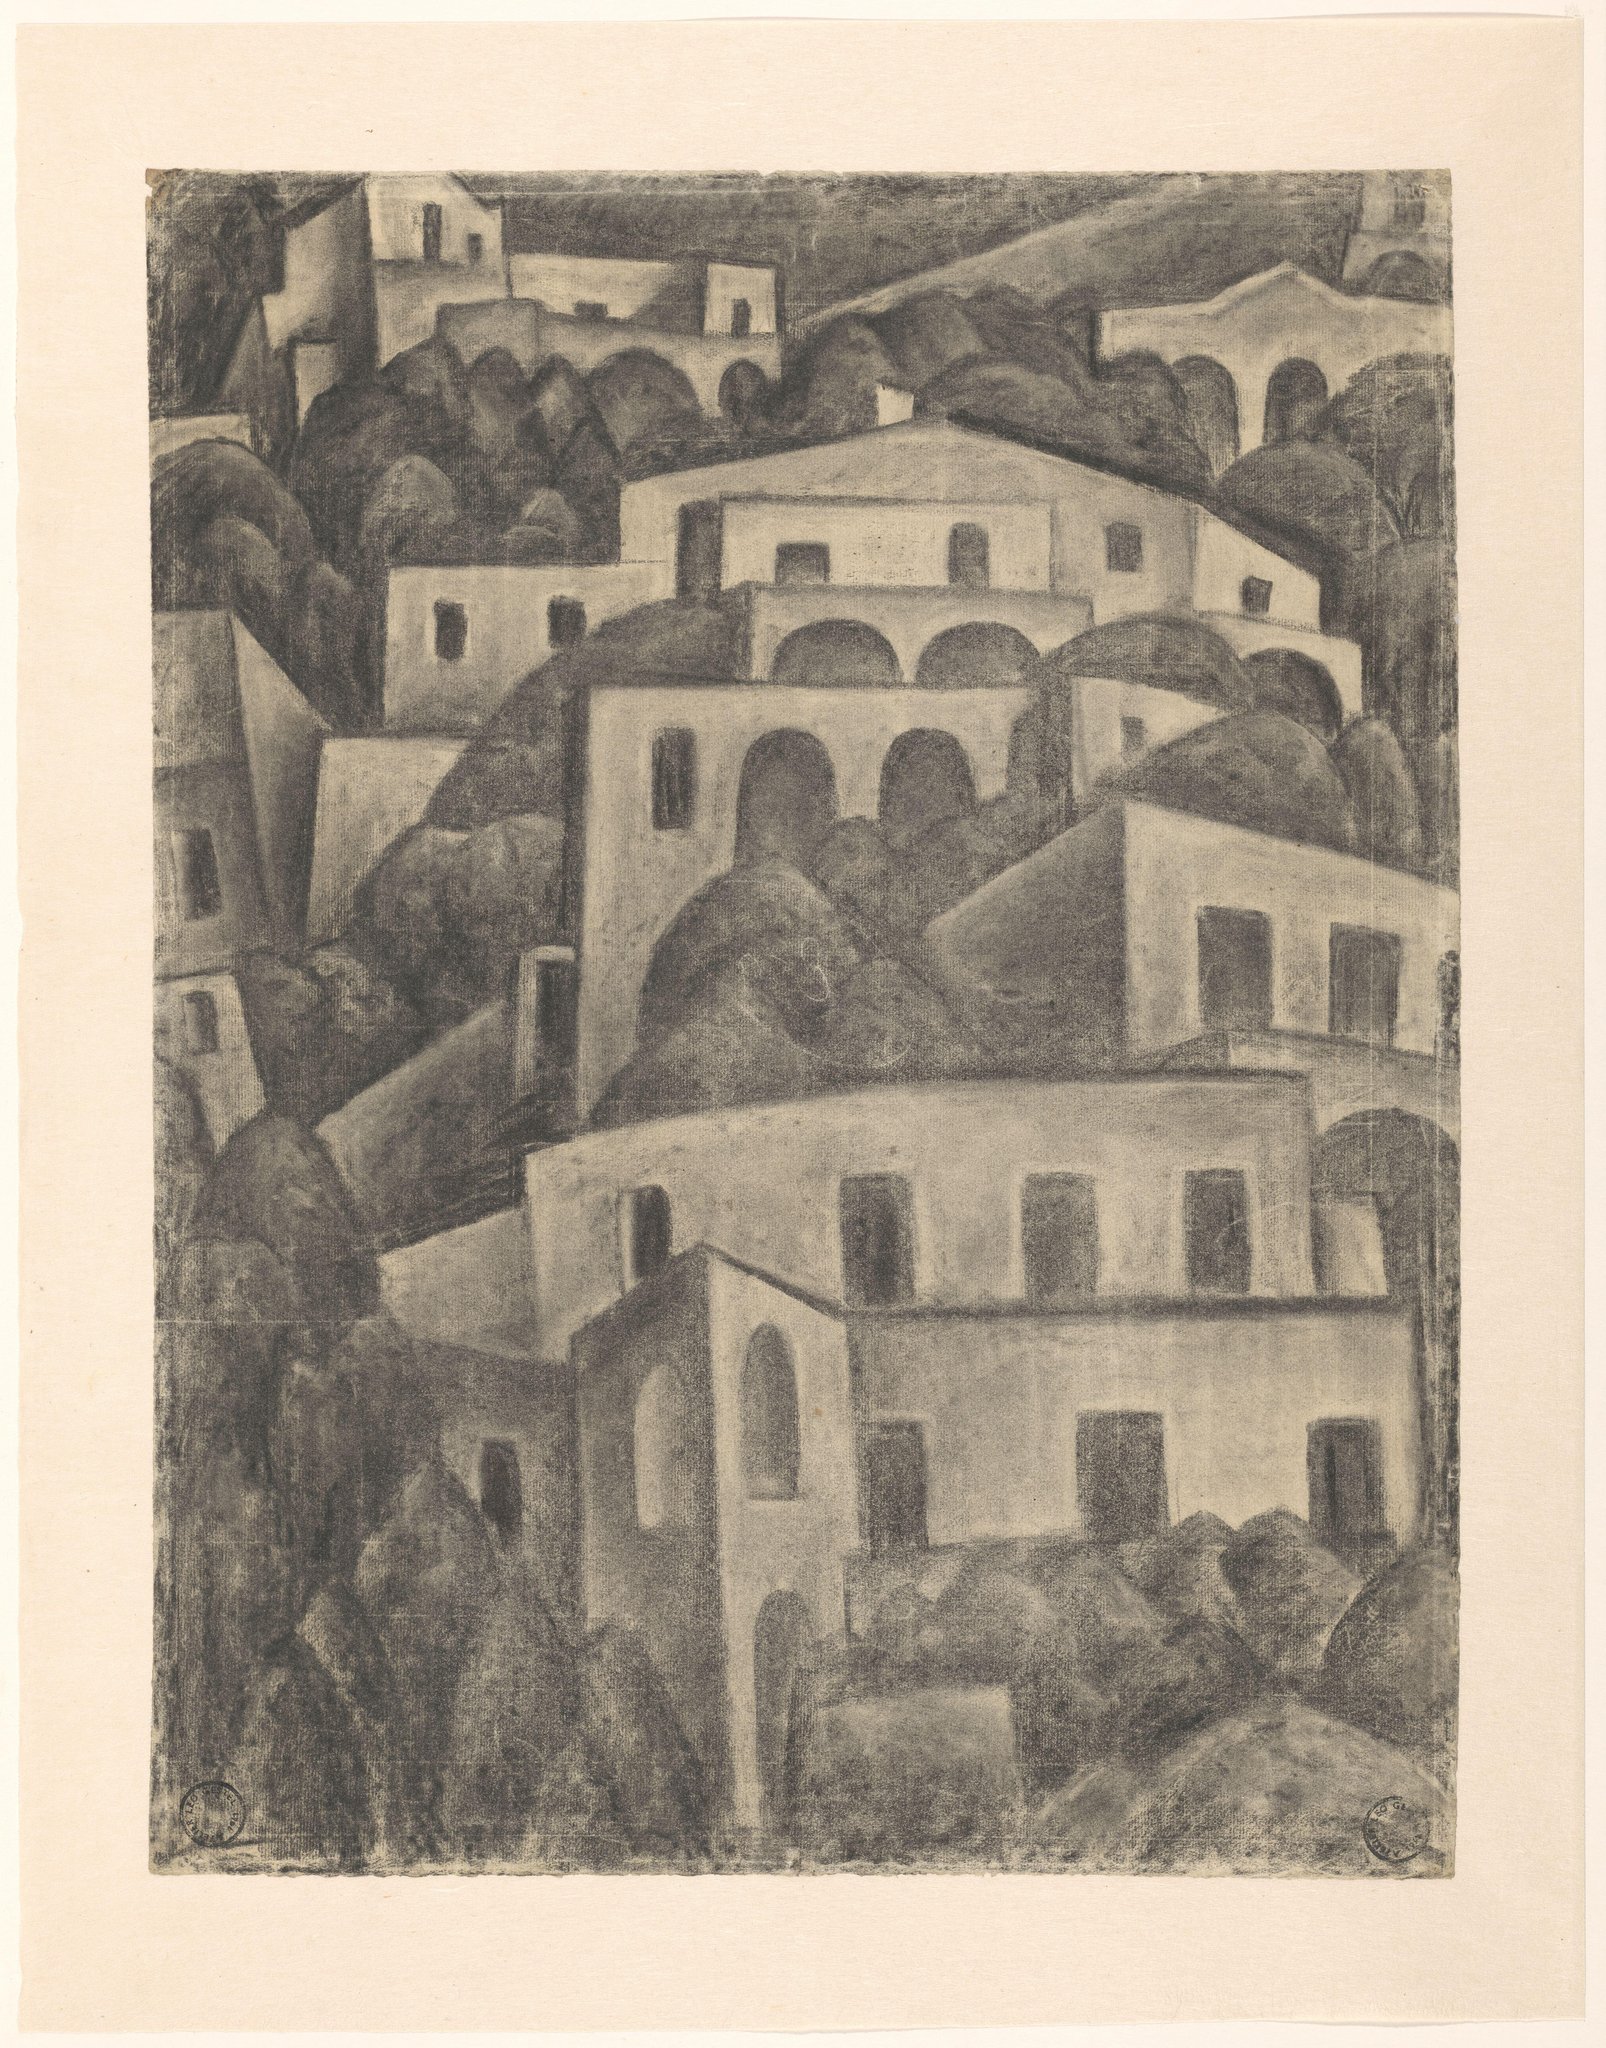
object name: drawing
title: Gezicht op Positano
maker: leo gestel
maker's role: draughtsman, print maker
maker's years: 1881-1941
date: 1924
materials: chalk, paper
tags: mountains, positano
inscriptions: collector's mark: Lugt 2228, workshop stamp: Lugt 1078a